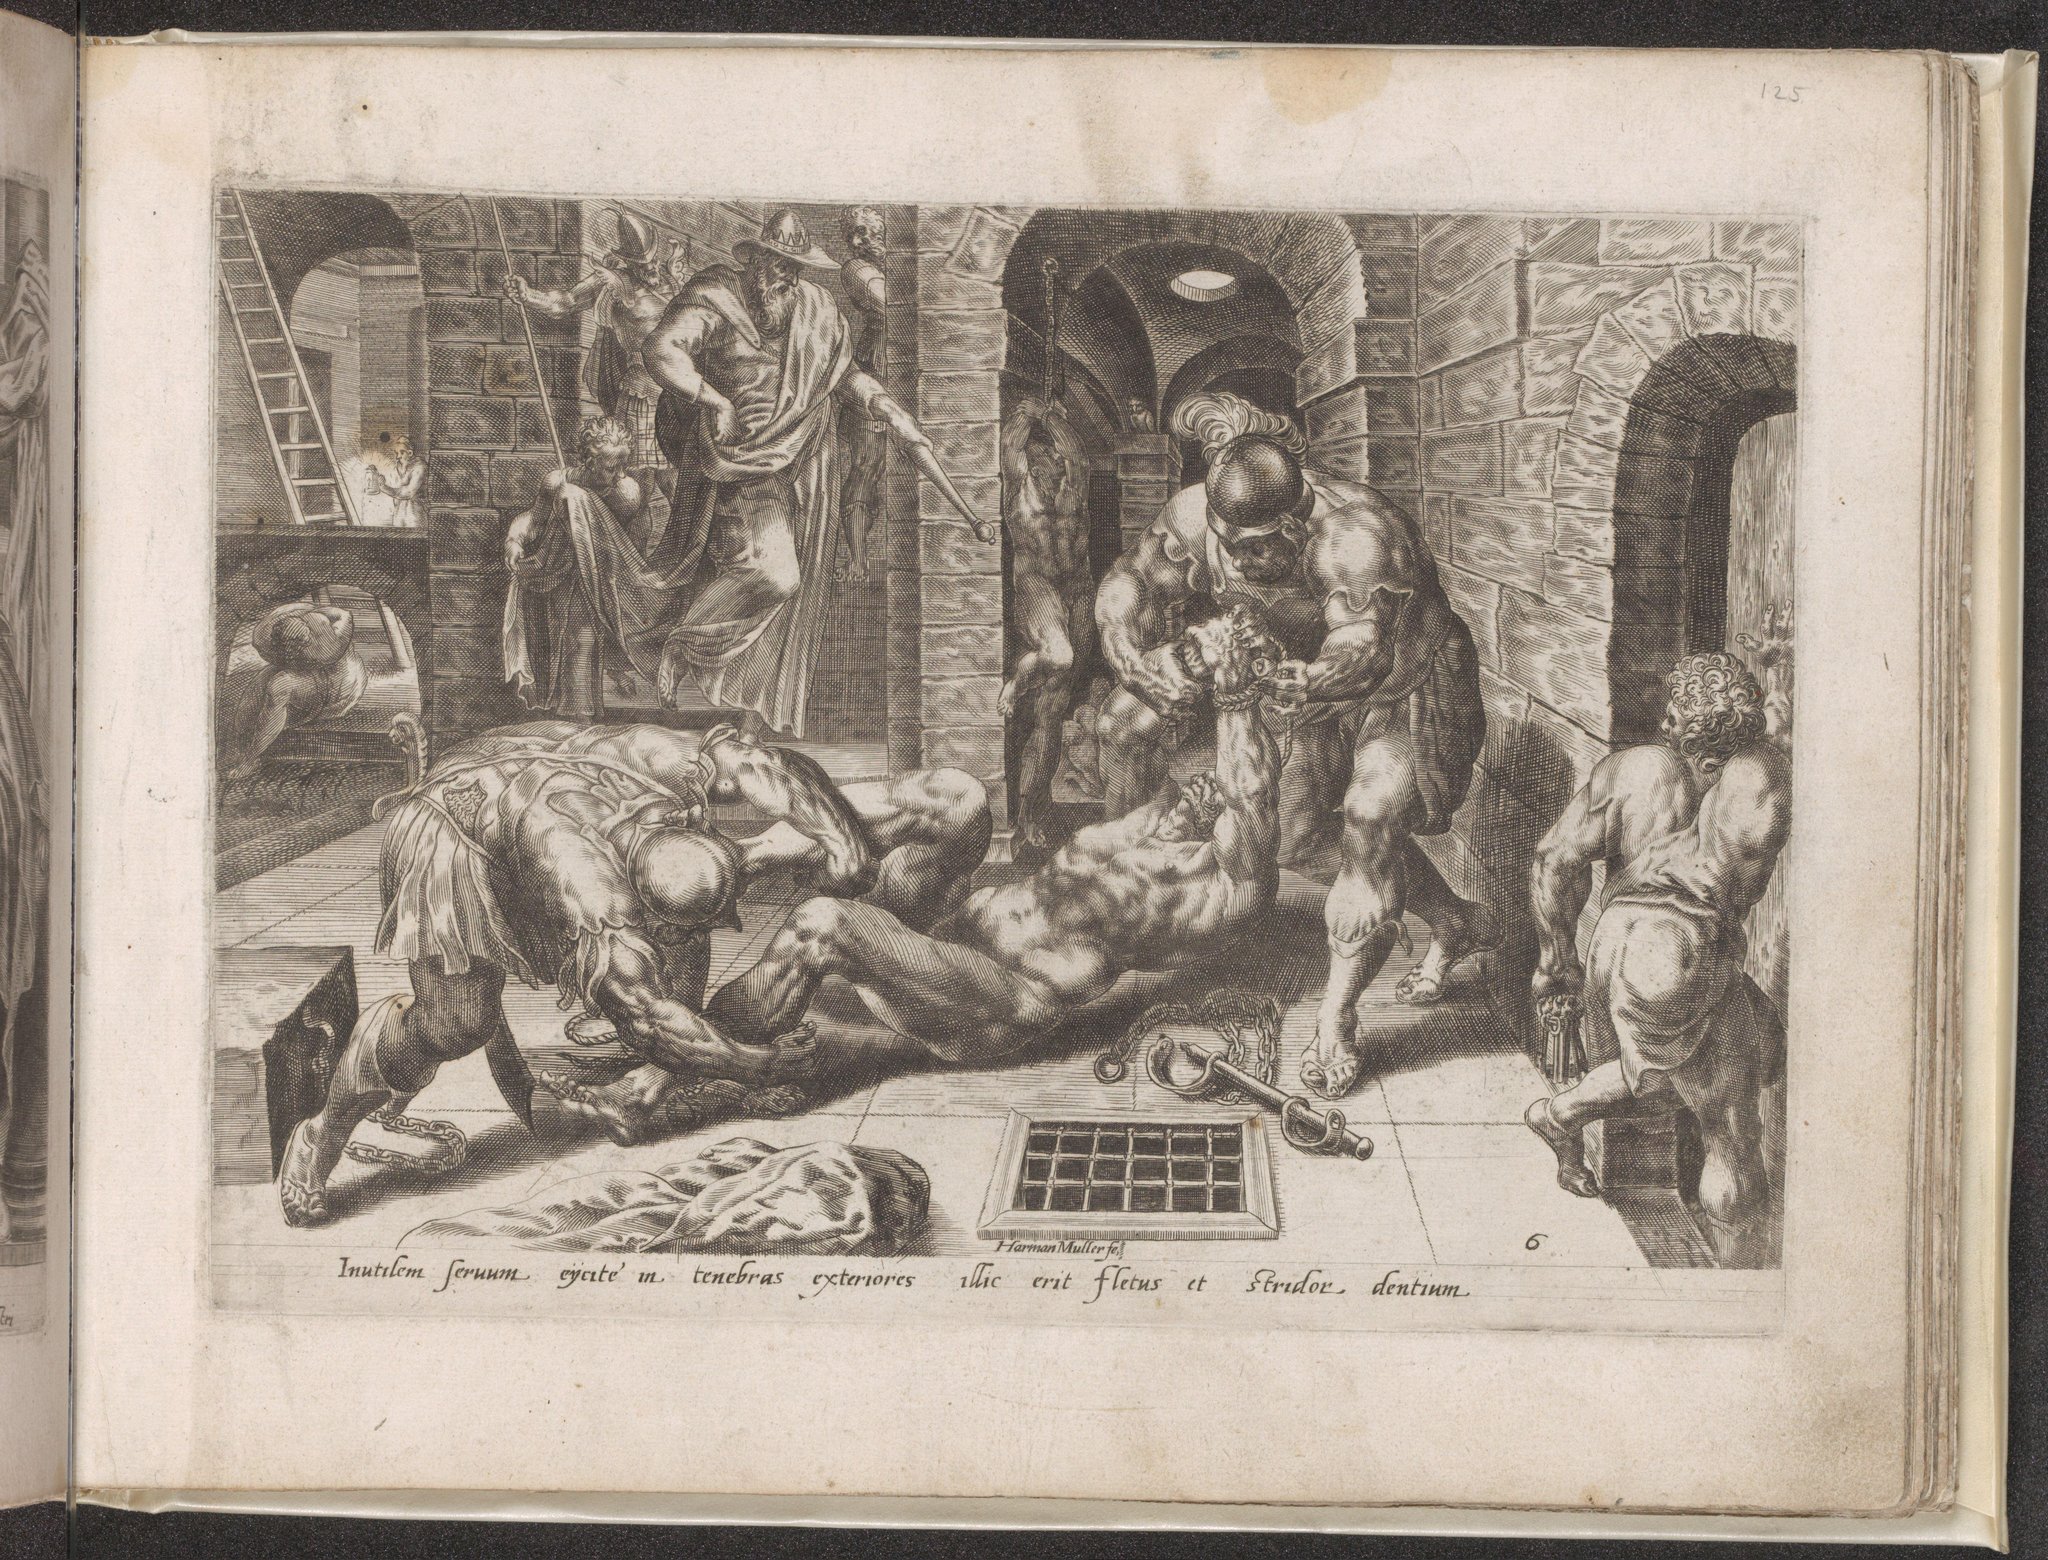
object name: album leaf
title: Slechte dienaar in een duistere kerker gegooid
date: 1565-1572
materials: paper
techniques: engraving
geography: antwerp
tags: two servants are rewarded, the third is cast into outer darkness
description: De slechte dienaar, die zijn talent had begraven, wordt aan handen en voeten gebonden en in een duistere kerker geplaatst. Onderaan de trap staat zijn heer, die de opdracht geeft om hem in de kerker te gooien. Onder de voorstelling een verwijzing in het Latijn naar de Bijbeltekst. Deze prent maakt deel uit van een album.